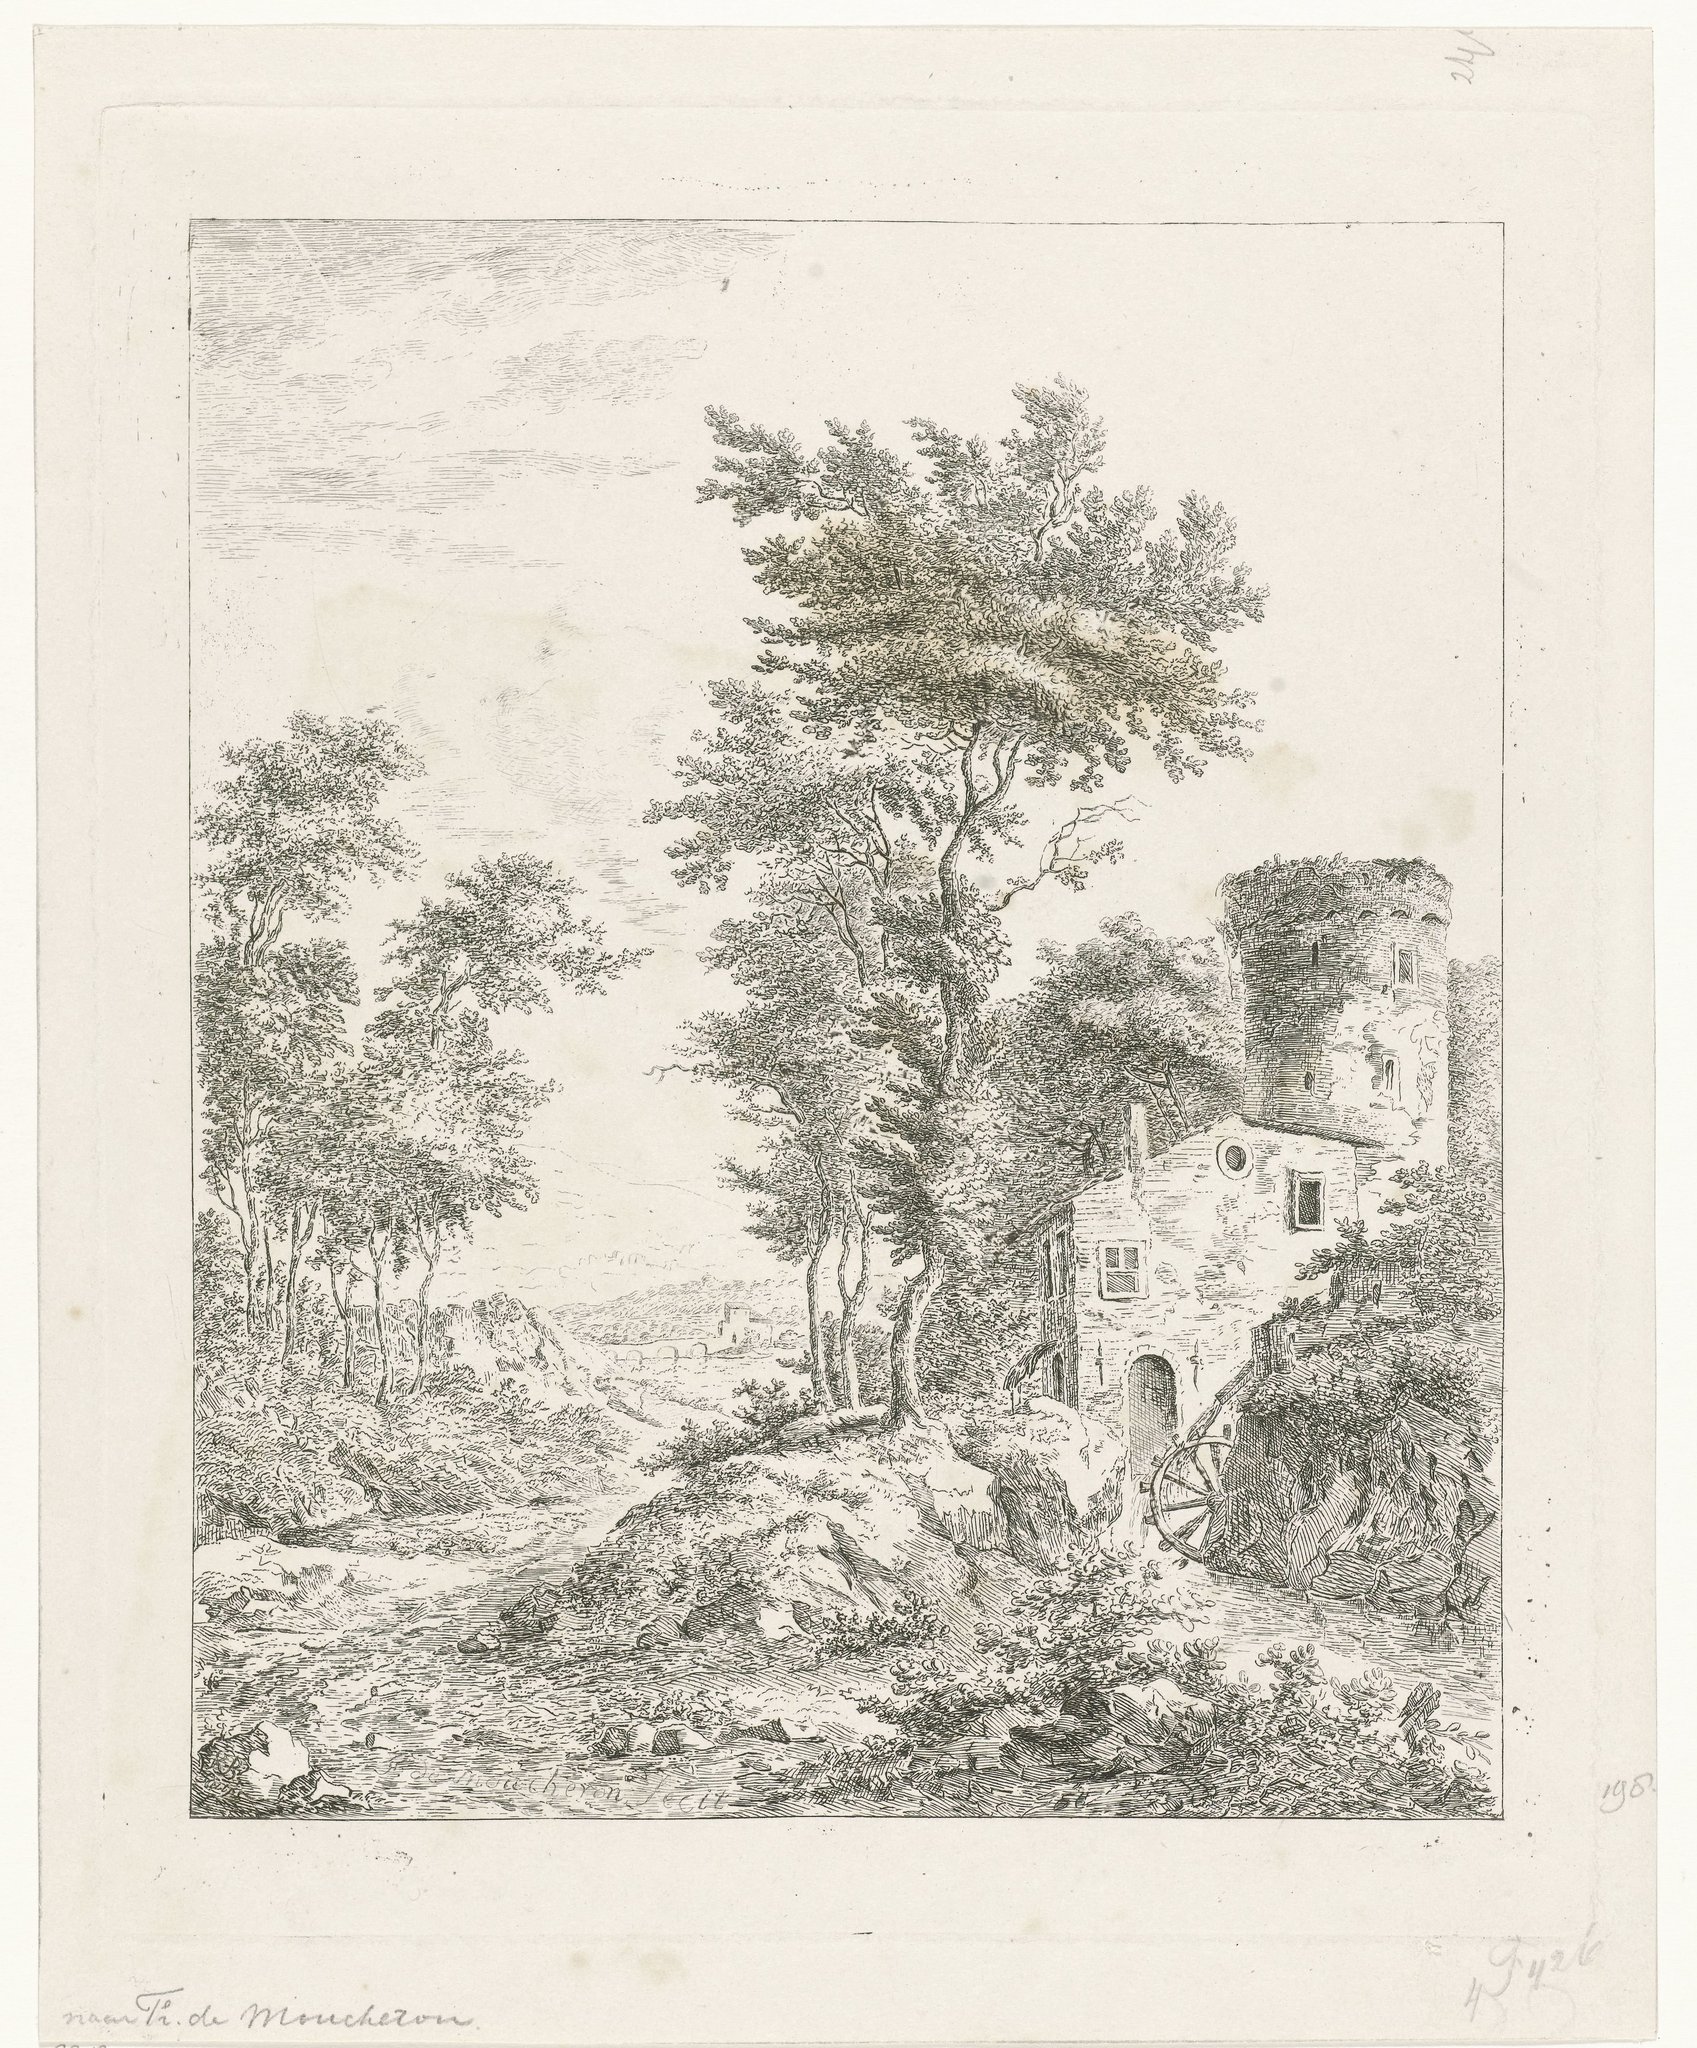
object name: print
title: Landschap met rivier en waterrad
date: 1796-1856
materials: paper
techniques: engraving, etching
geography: vaassen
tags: river, farm or solitary house in landscape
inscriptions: collector's mark: Lugt 2228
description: Een naar beneden stromende rivier met bomen aan weerszijden. Links een huis met een toren en waterrad. Op de achtergrond een dal met een brug of aquaduct.